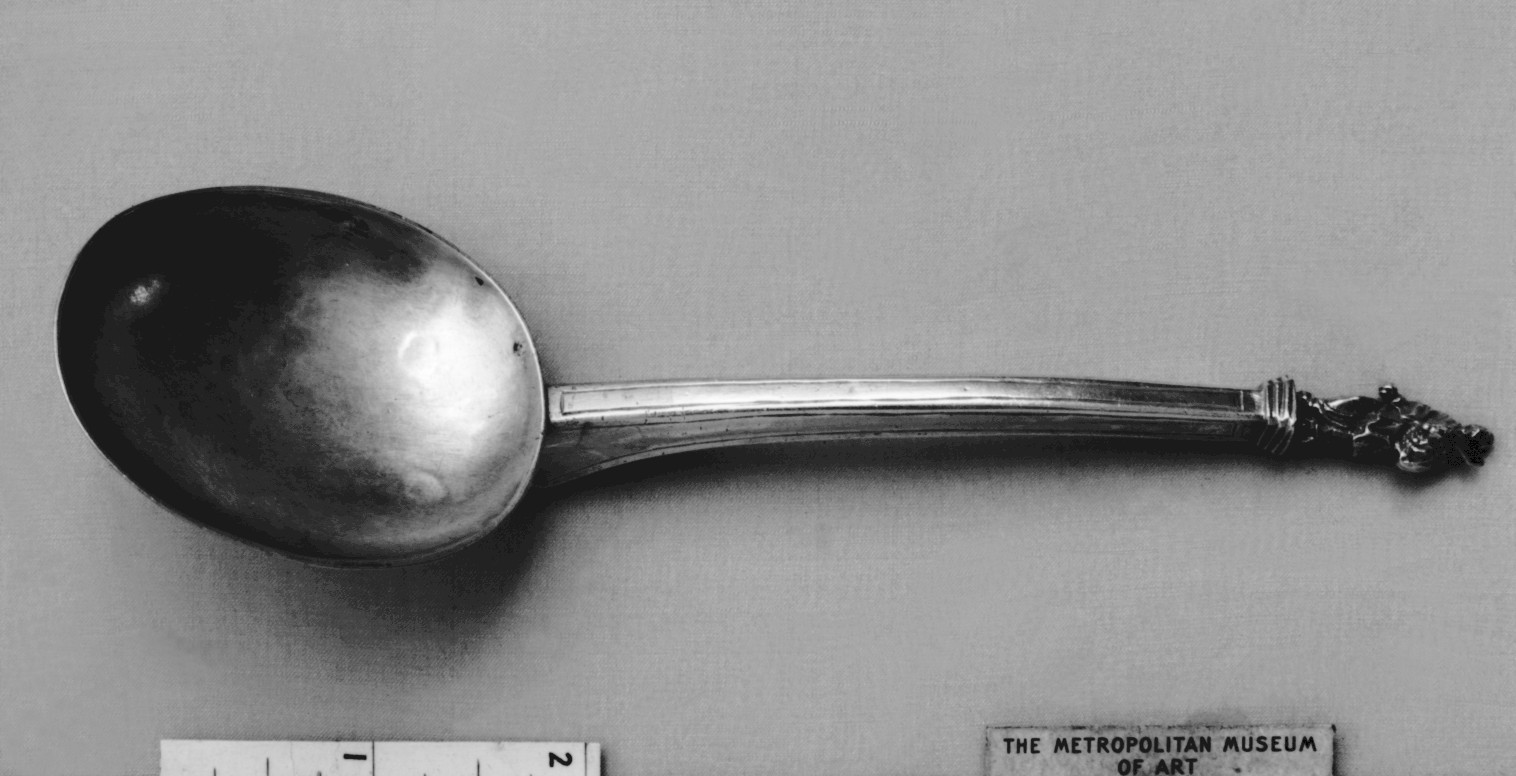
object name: apostle spoon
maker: hans schleich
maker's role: maker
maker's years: 1516-1616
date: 1601-1650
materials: gilt, silver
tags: apostles